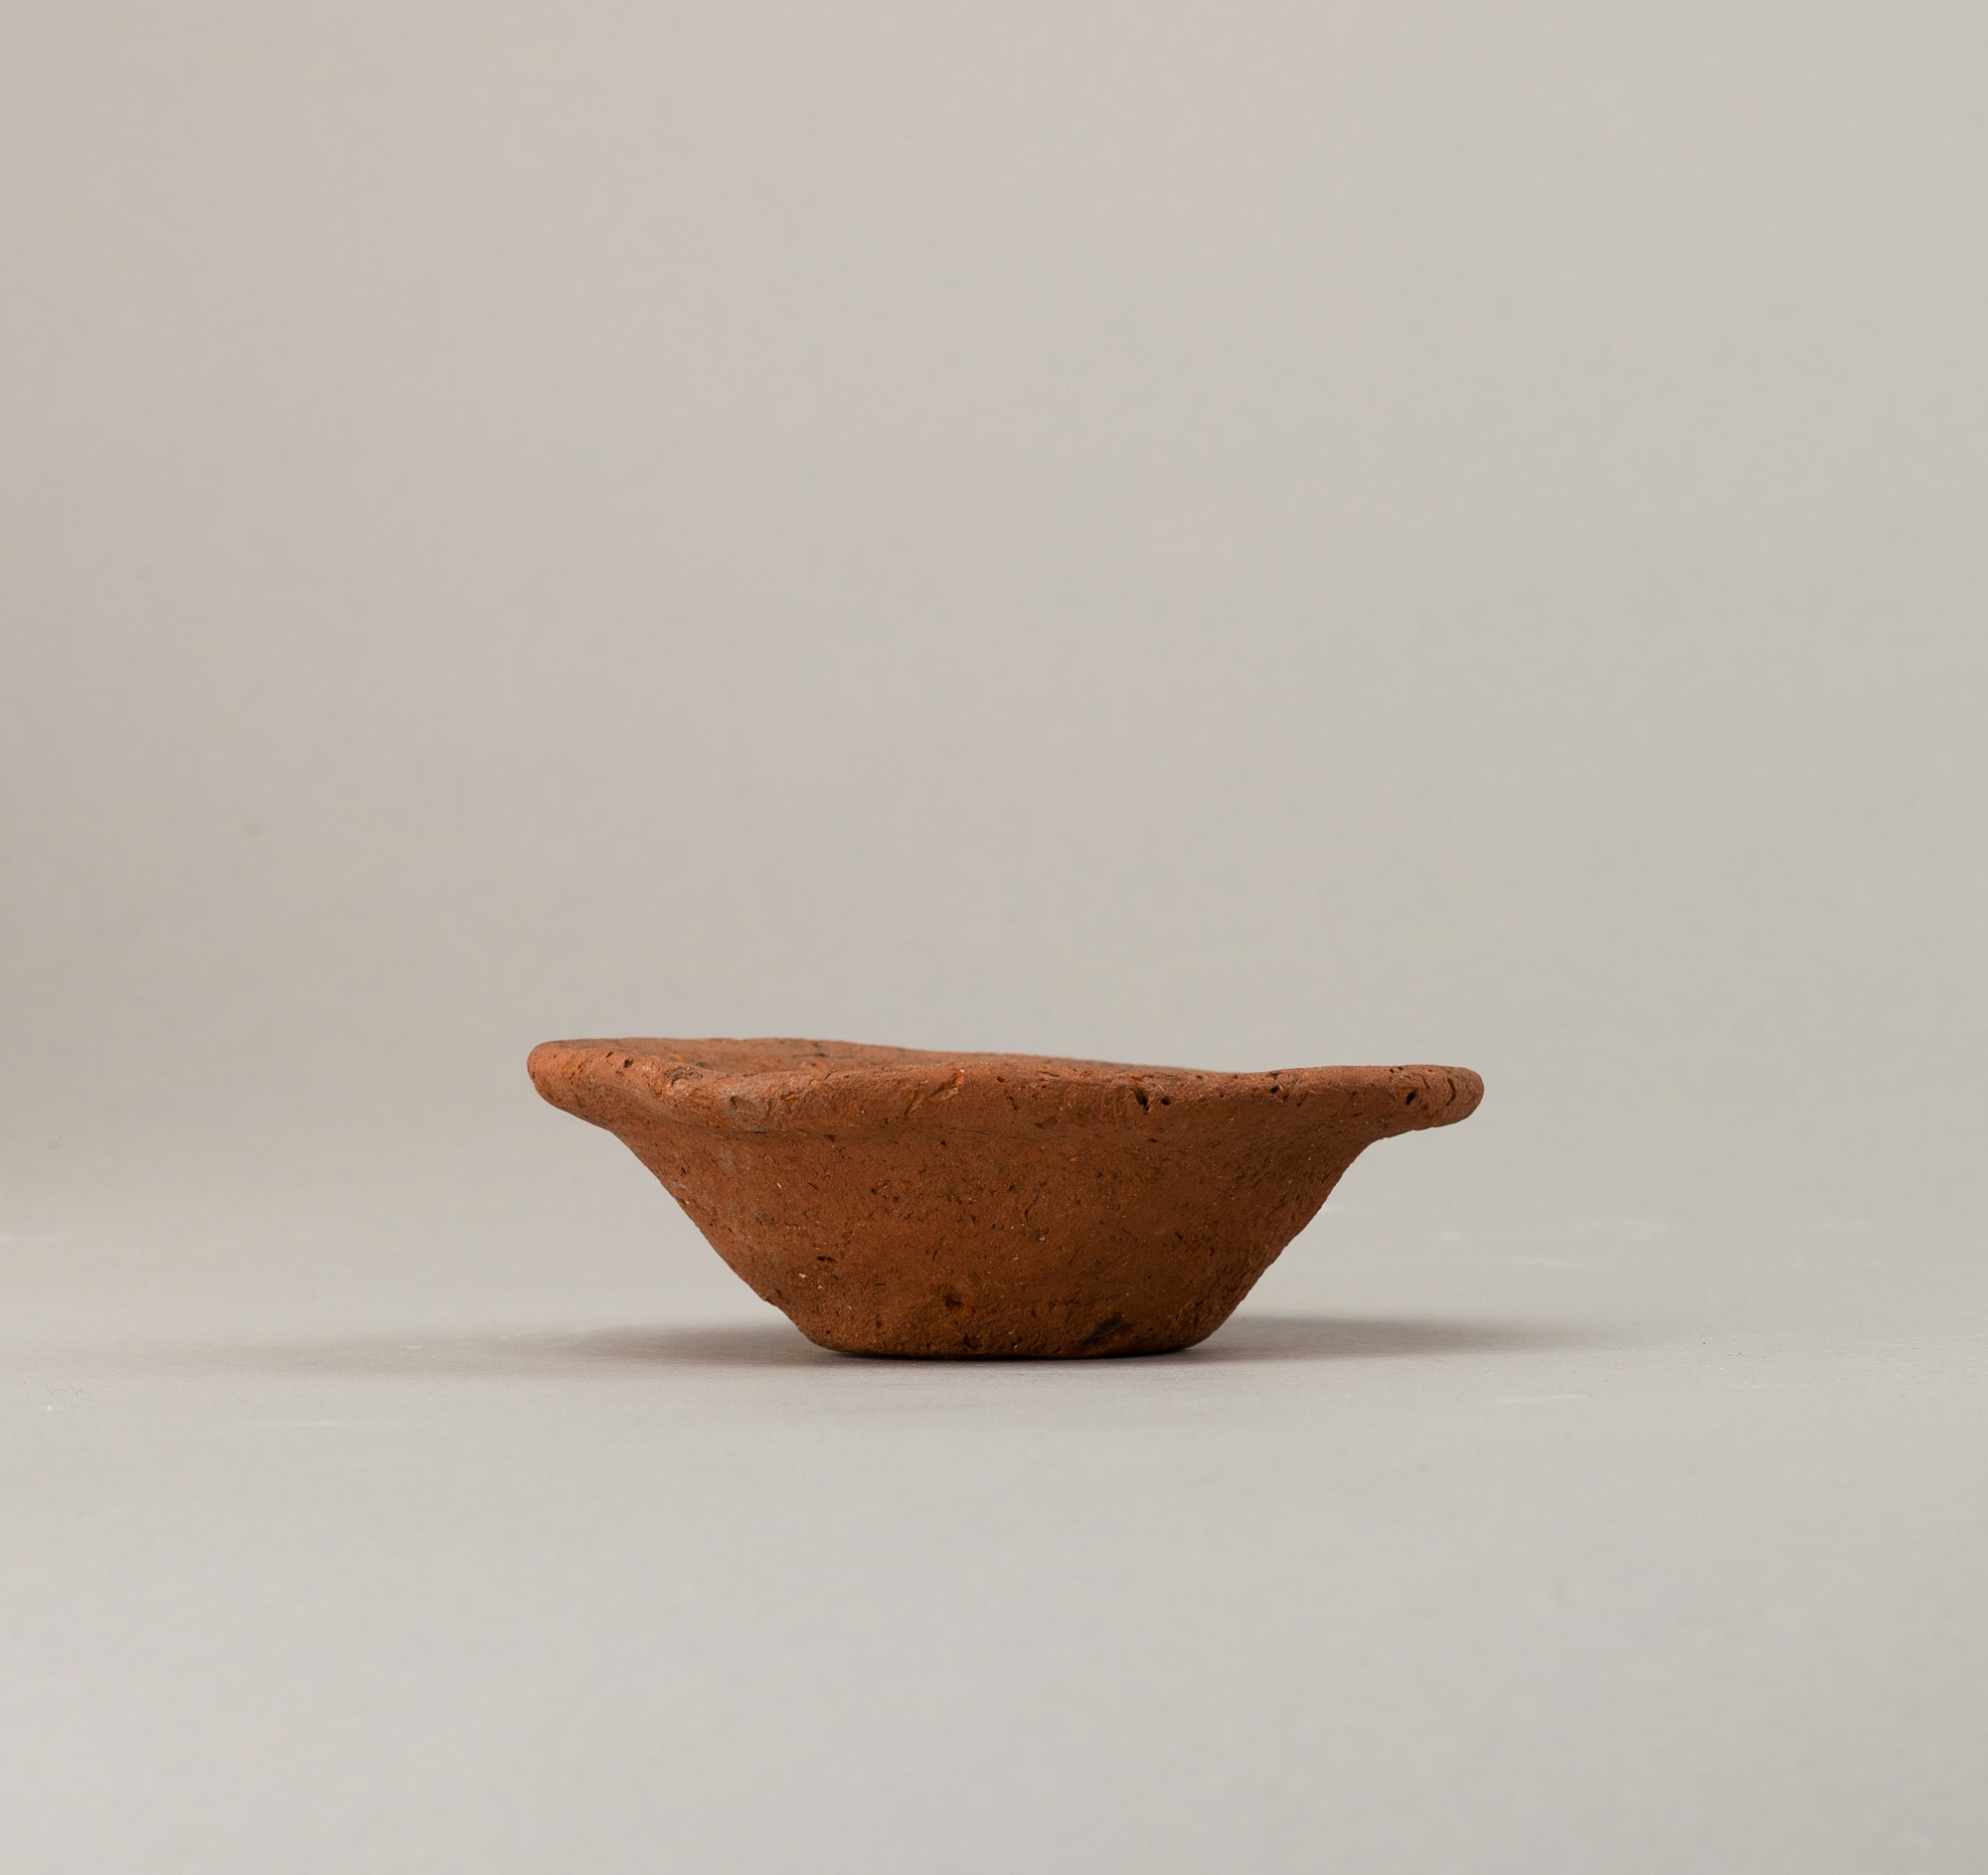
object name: dish saucer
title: Small saucer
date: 3100-2650 BCE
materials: pottery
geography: egypt